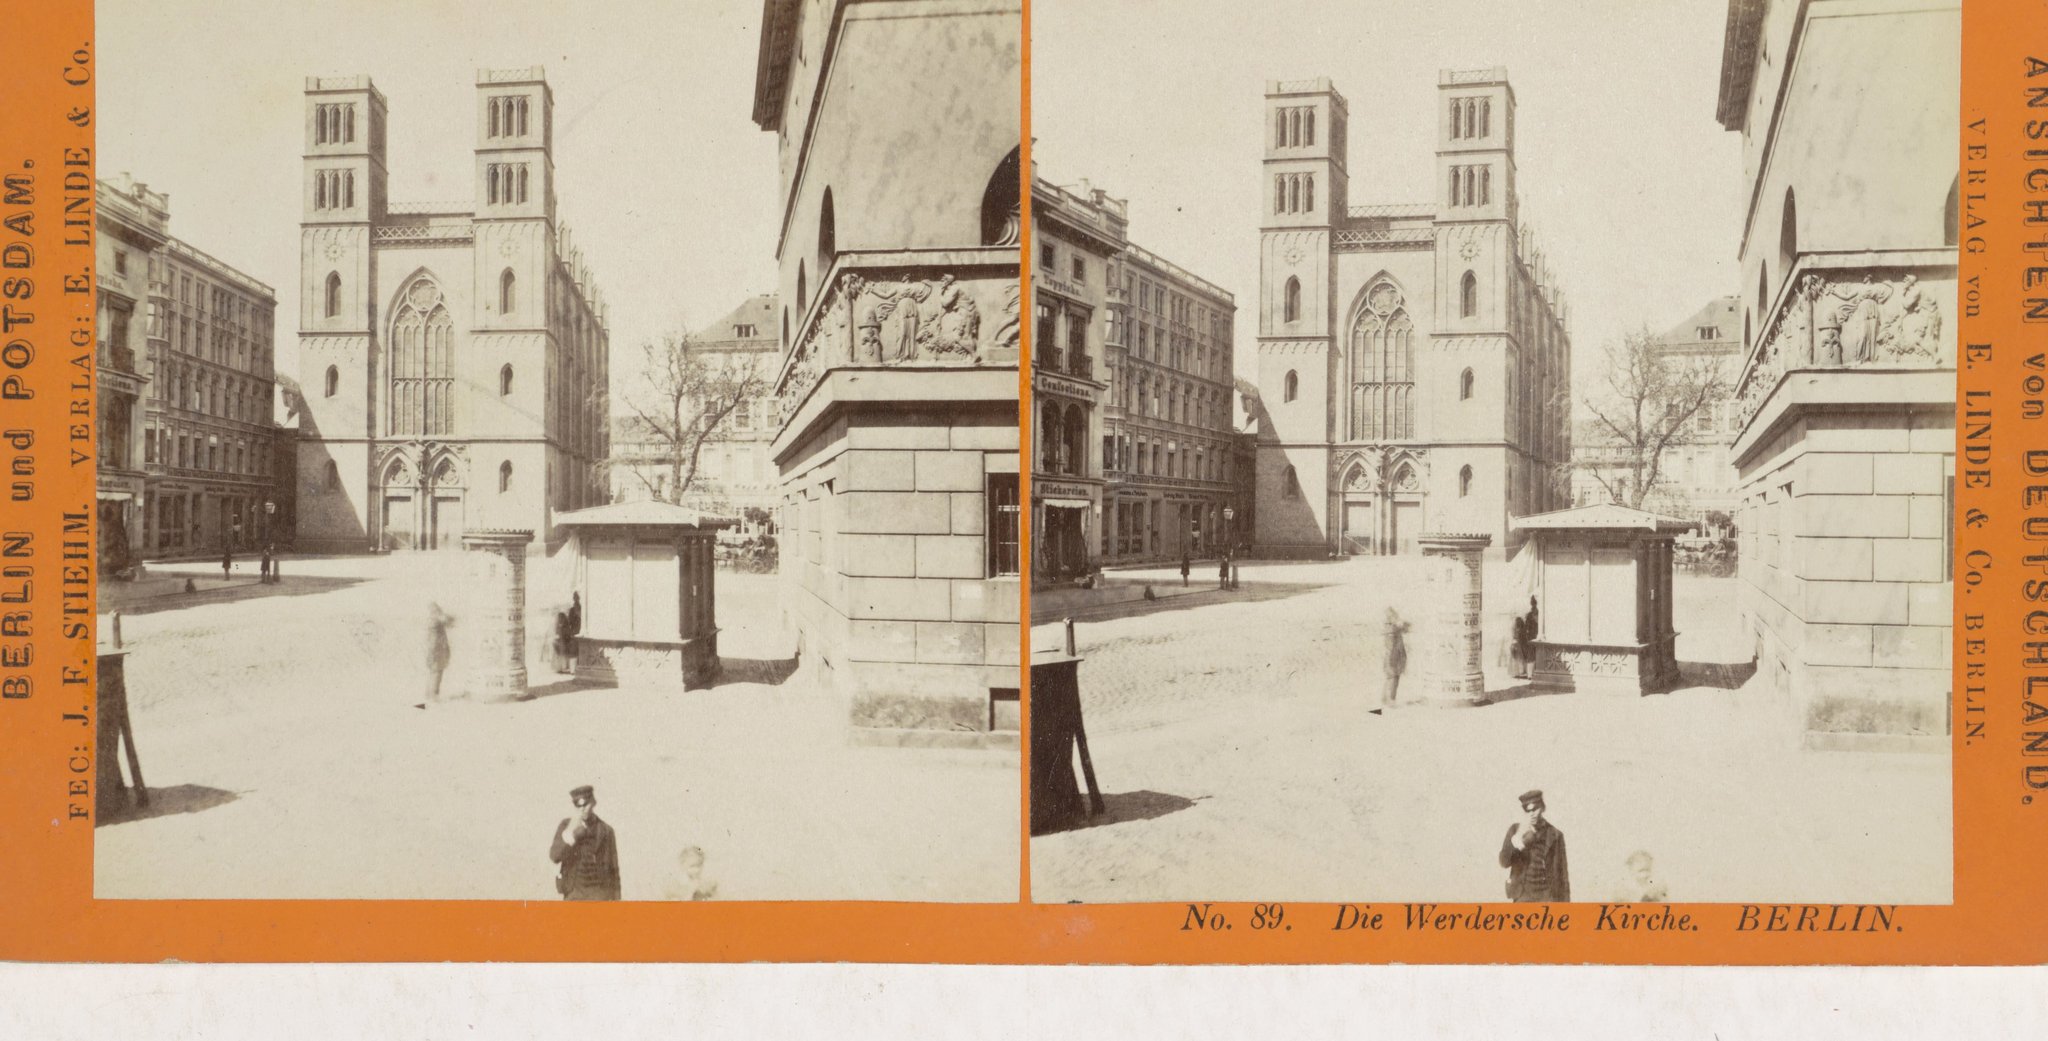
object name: stereograph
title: Die Werdersche Kirche. Berlin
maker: johann friedrich stiehm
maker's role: fotograaf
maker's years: 1826-1902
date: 1868-1870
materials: cardboard, paper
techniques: albumen print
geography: werderscher markt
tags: roman catholic church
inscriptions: number: ‘No. 89.’